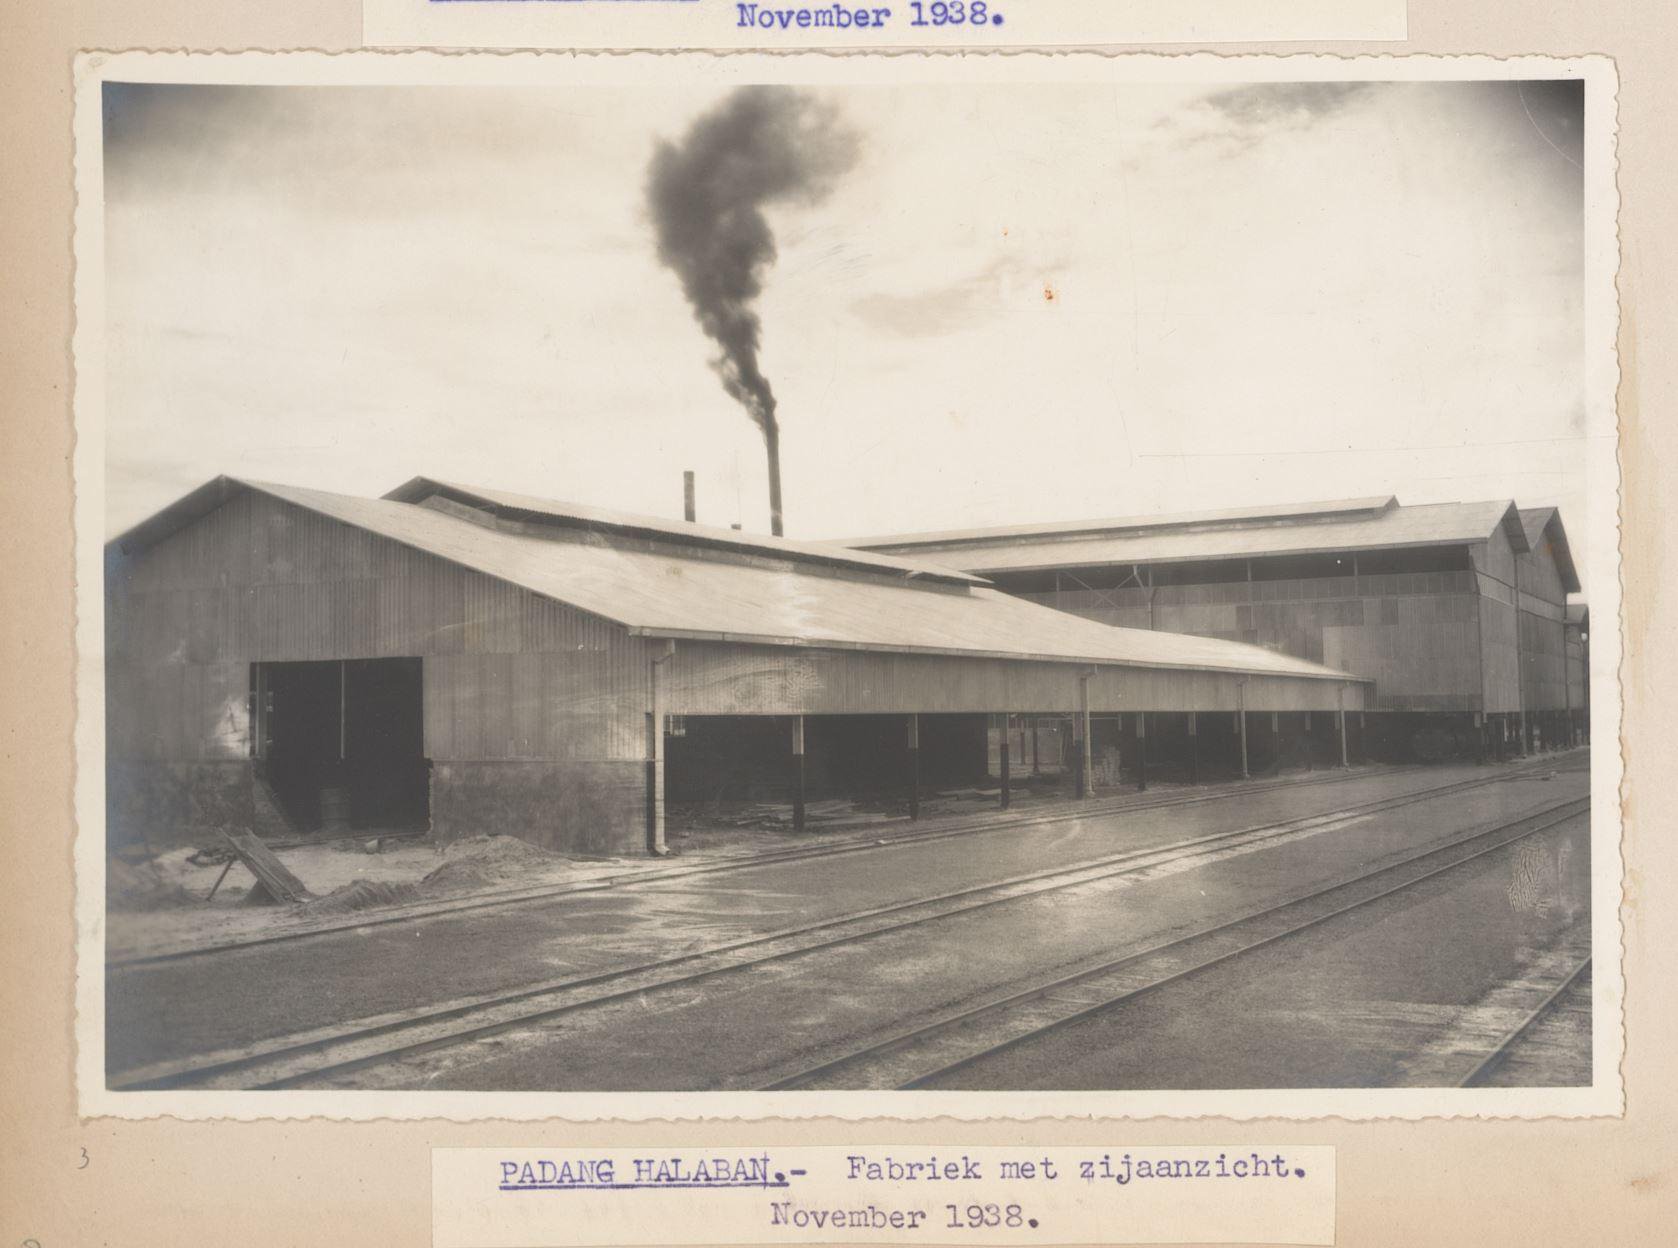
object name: photograph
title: Padang Halaban - Fabriek met zijaanzicht. November 1938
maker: Anonymous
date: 1911-1938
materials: photographic support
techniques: gelatin silver print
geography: sumatra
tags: plantation, factory-building, (non-fruit) products of plants or trees: palm oil, sumatra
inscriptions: inscription: ‘Padang Halaban - Fabriek met zijaanzicht. November 1938’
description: Gezicht op de palmoliefabriek op de plantage Padang Halaban, november 1938. Op de voorgrond enkele treinsporen. Onderdeel van het fotoalbum over de plantages Pernantian en Brussel van de Sumatra Caoutchouc Maatschappij op de Oostkust van Sumatra in de jaren 1935-1939.